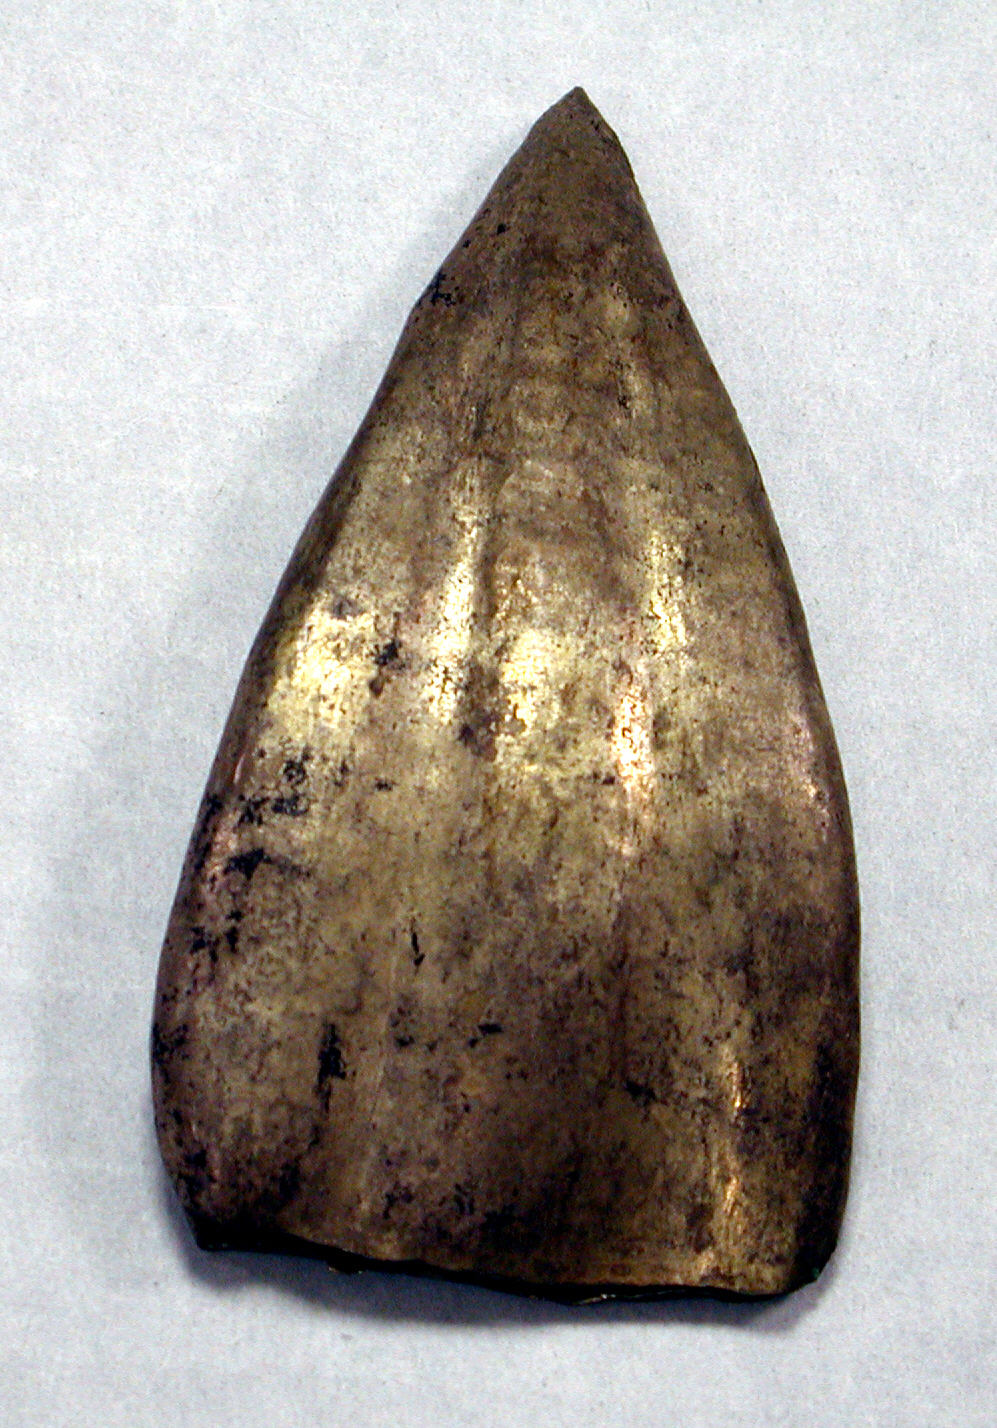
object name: ornament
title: Hammered Silver Petal Ornament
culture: peruvian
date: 701-1566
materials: gilt, silver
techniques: hammering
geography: peru